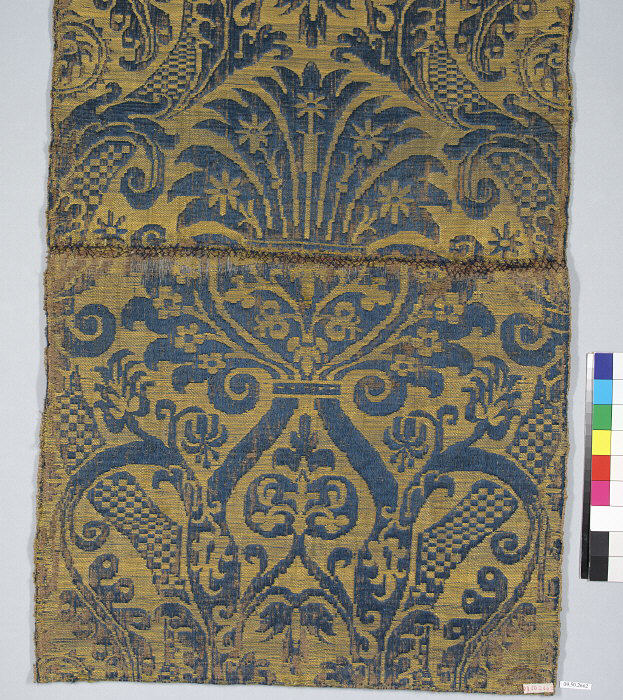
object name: piece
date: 1501-1700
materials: hemp, silk